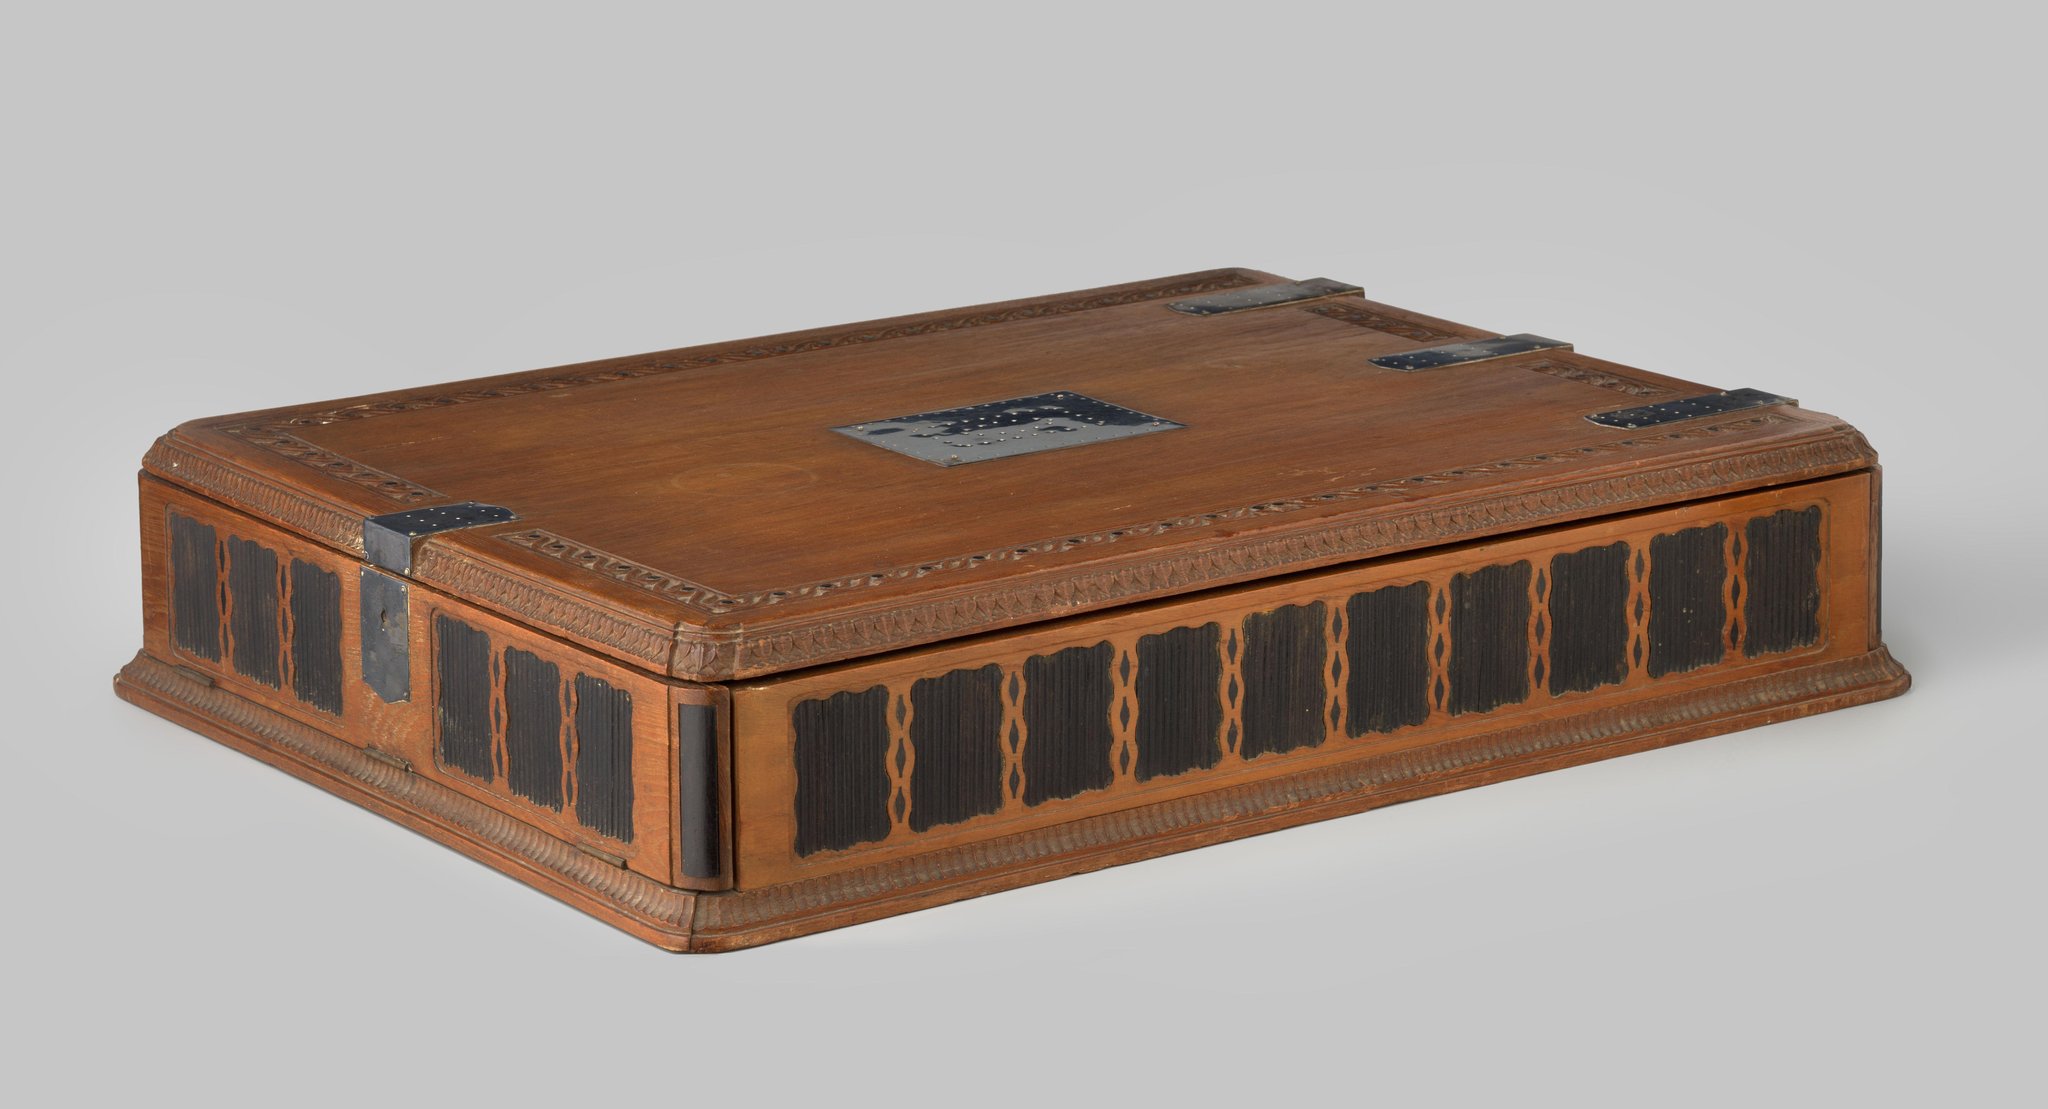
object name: chest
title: Kist behorend bij fotoalbum aangeboden aan F.J. Wirix door het personeel van de Suikeronderneming Djatiroto in 1917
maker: Anonymous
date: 1917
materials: textile, wood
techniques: inlay, carving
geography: java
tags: djatiroto, suikeronderneming, handels vereeniging amsterdam, administrateur, f.j. wirix, jatiroto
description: Kist is ingelegd met een rechthoek van zwart hout. De binnenrand van de rechthoek is recht, de buitenrand is golvend. Over het oppervlak loopt een lengtestreep in reliëf. Centraal op het deksel een metalen rechthoek rondom versierd met gaatjes. Links drie sloten met gaatjes versierd. Rechts een slot. De rechterzijde van de kist is uitklapbaar. De binnenzijde van de kist is bekleed met paars satijn dat is vastgezet met knopen van dezelfde stof. De kist behoort bij het fotoalbum aangeboden aan F.J. Wirix door het personeel van de Suikeronderneming Djatiroto in 1917.